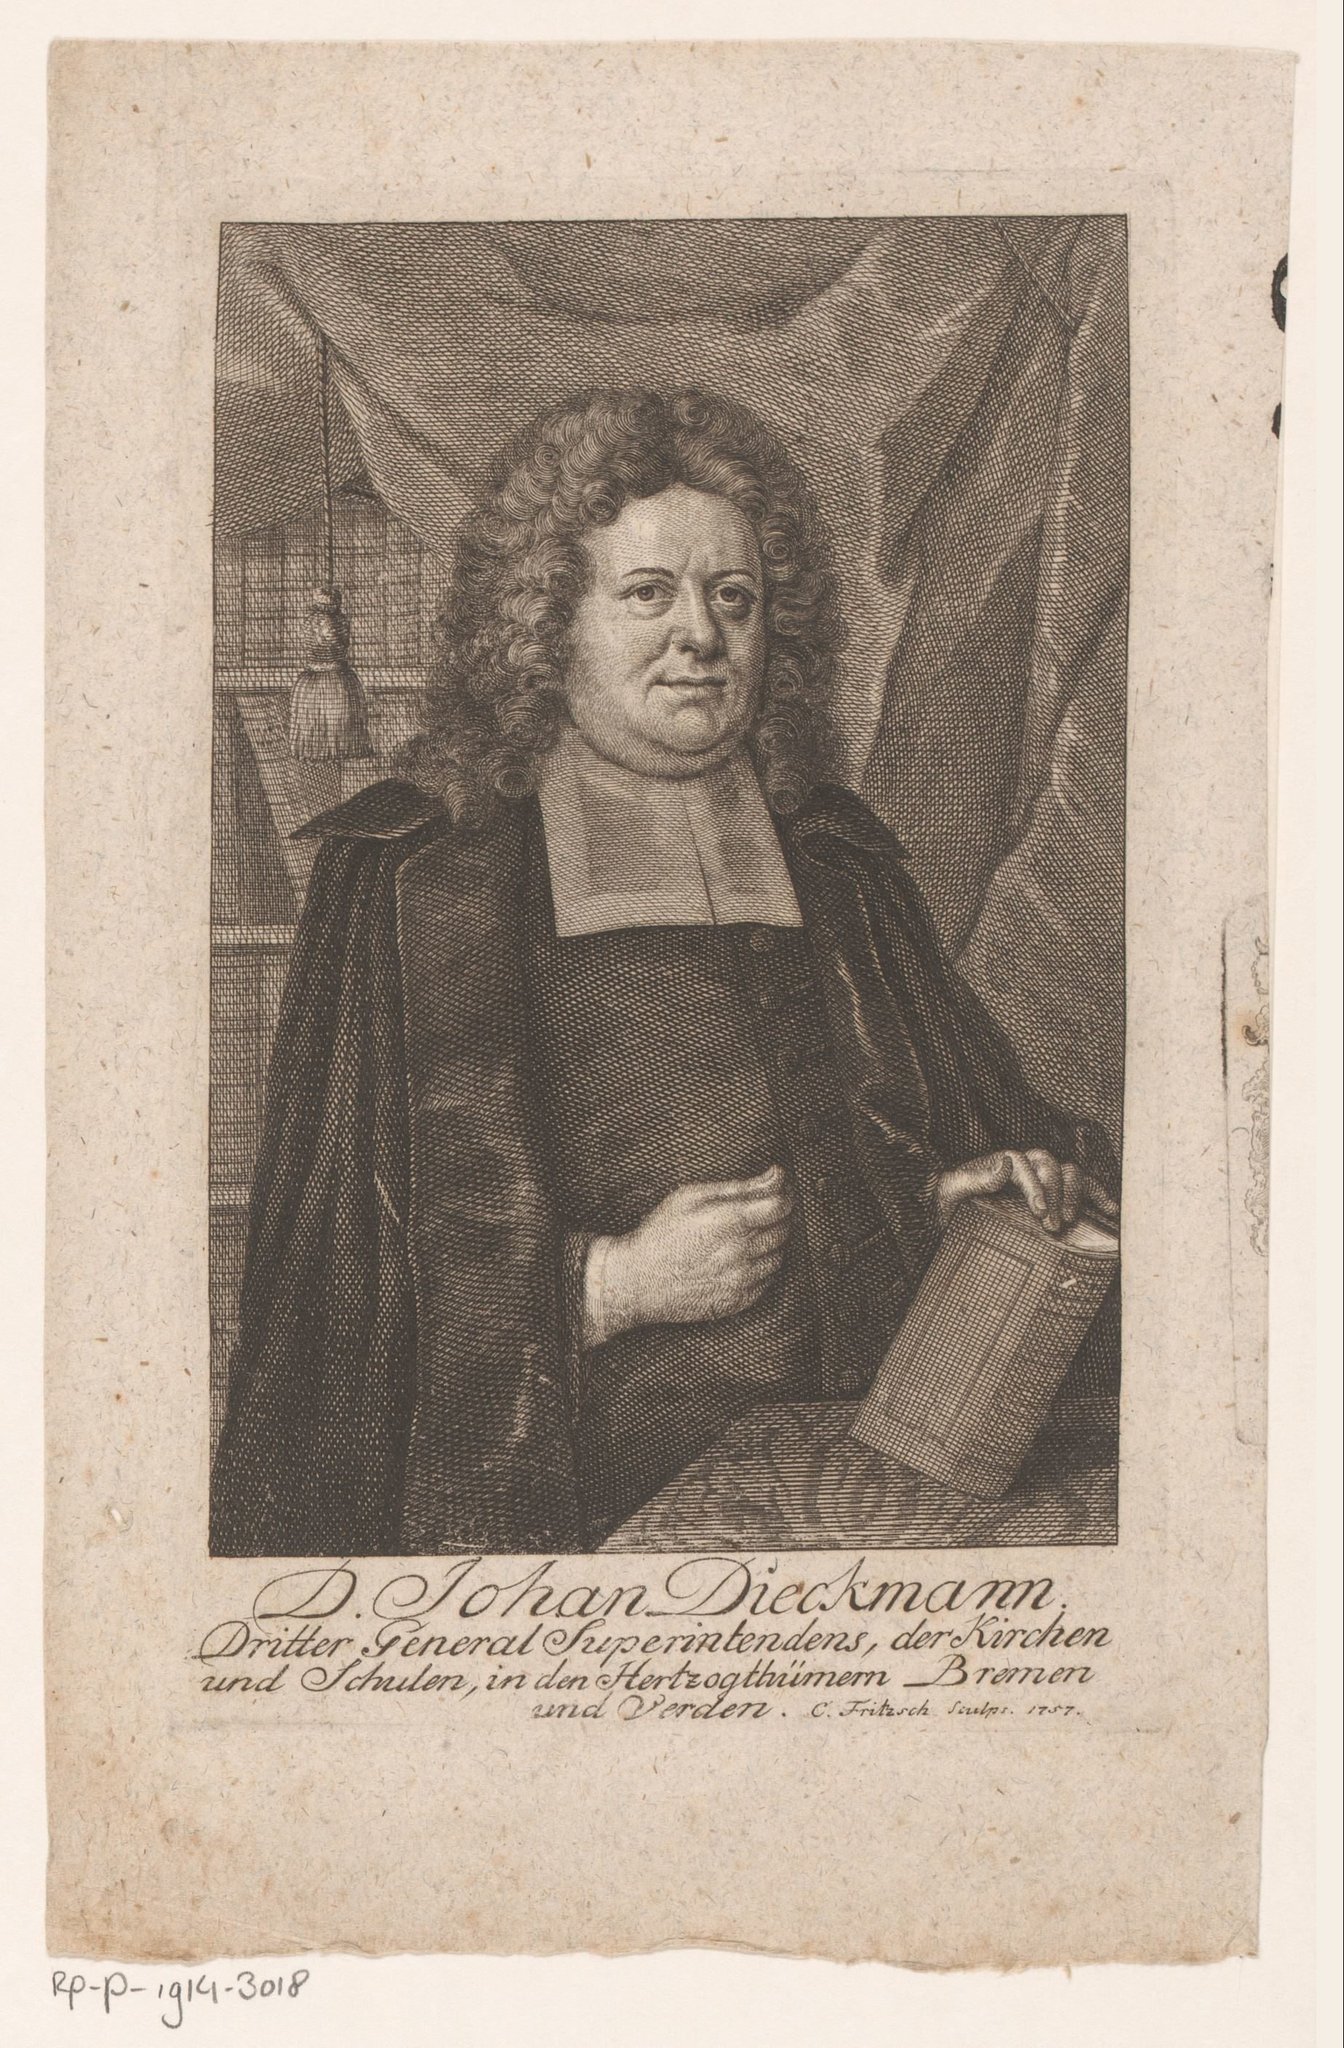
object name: print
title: Portret van Johann Dieckmann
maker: christian fritzsch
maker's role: print maker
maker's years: 1695-1769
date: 1757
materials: paper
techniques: engraving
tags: bookshelves, theologian, historical persons, book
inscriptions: collector's mark: Lugt 2228